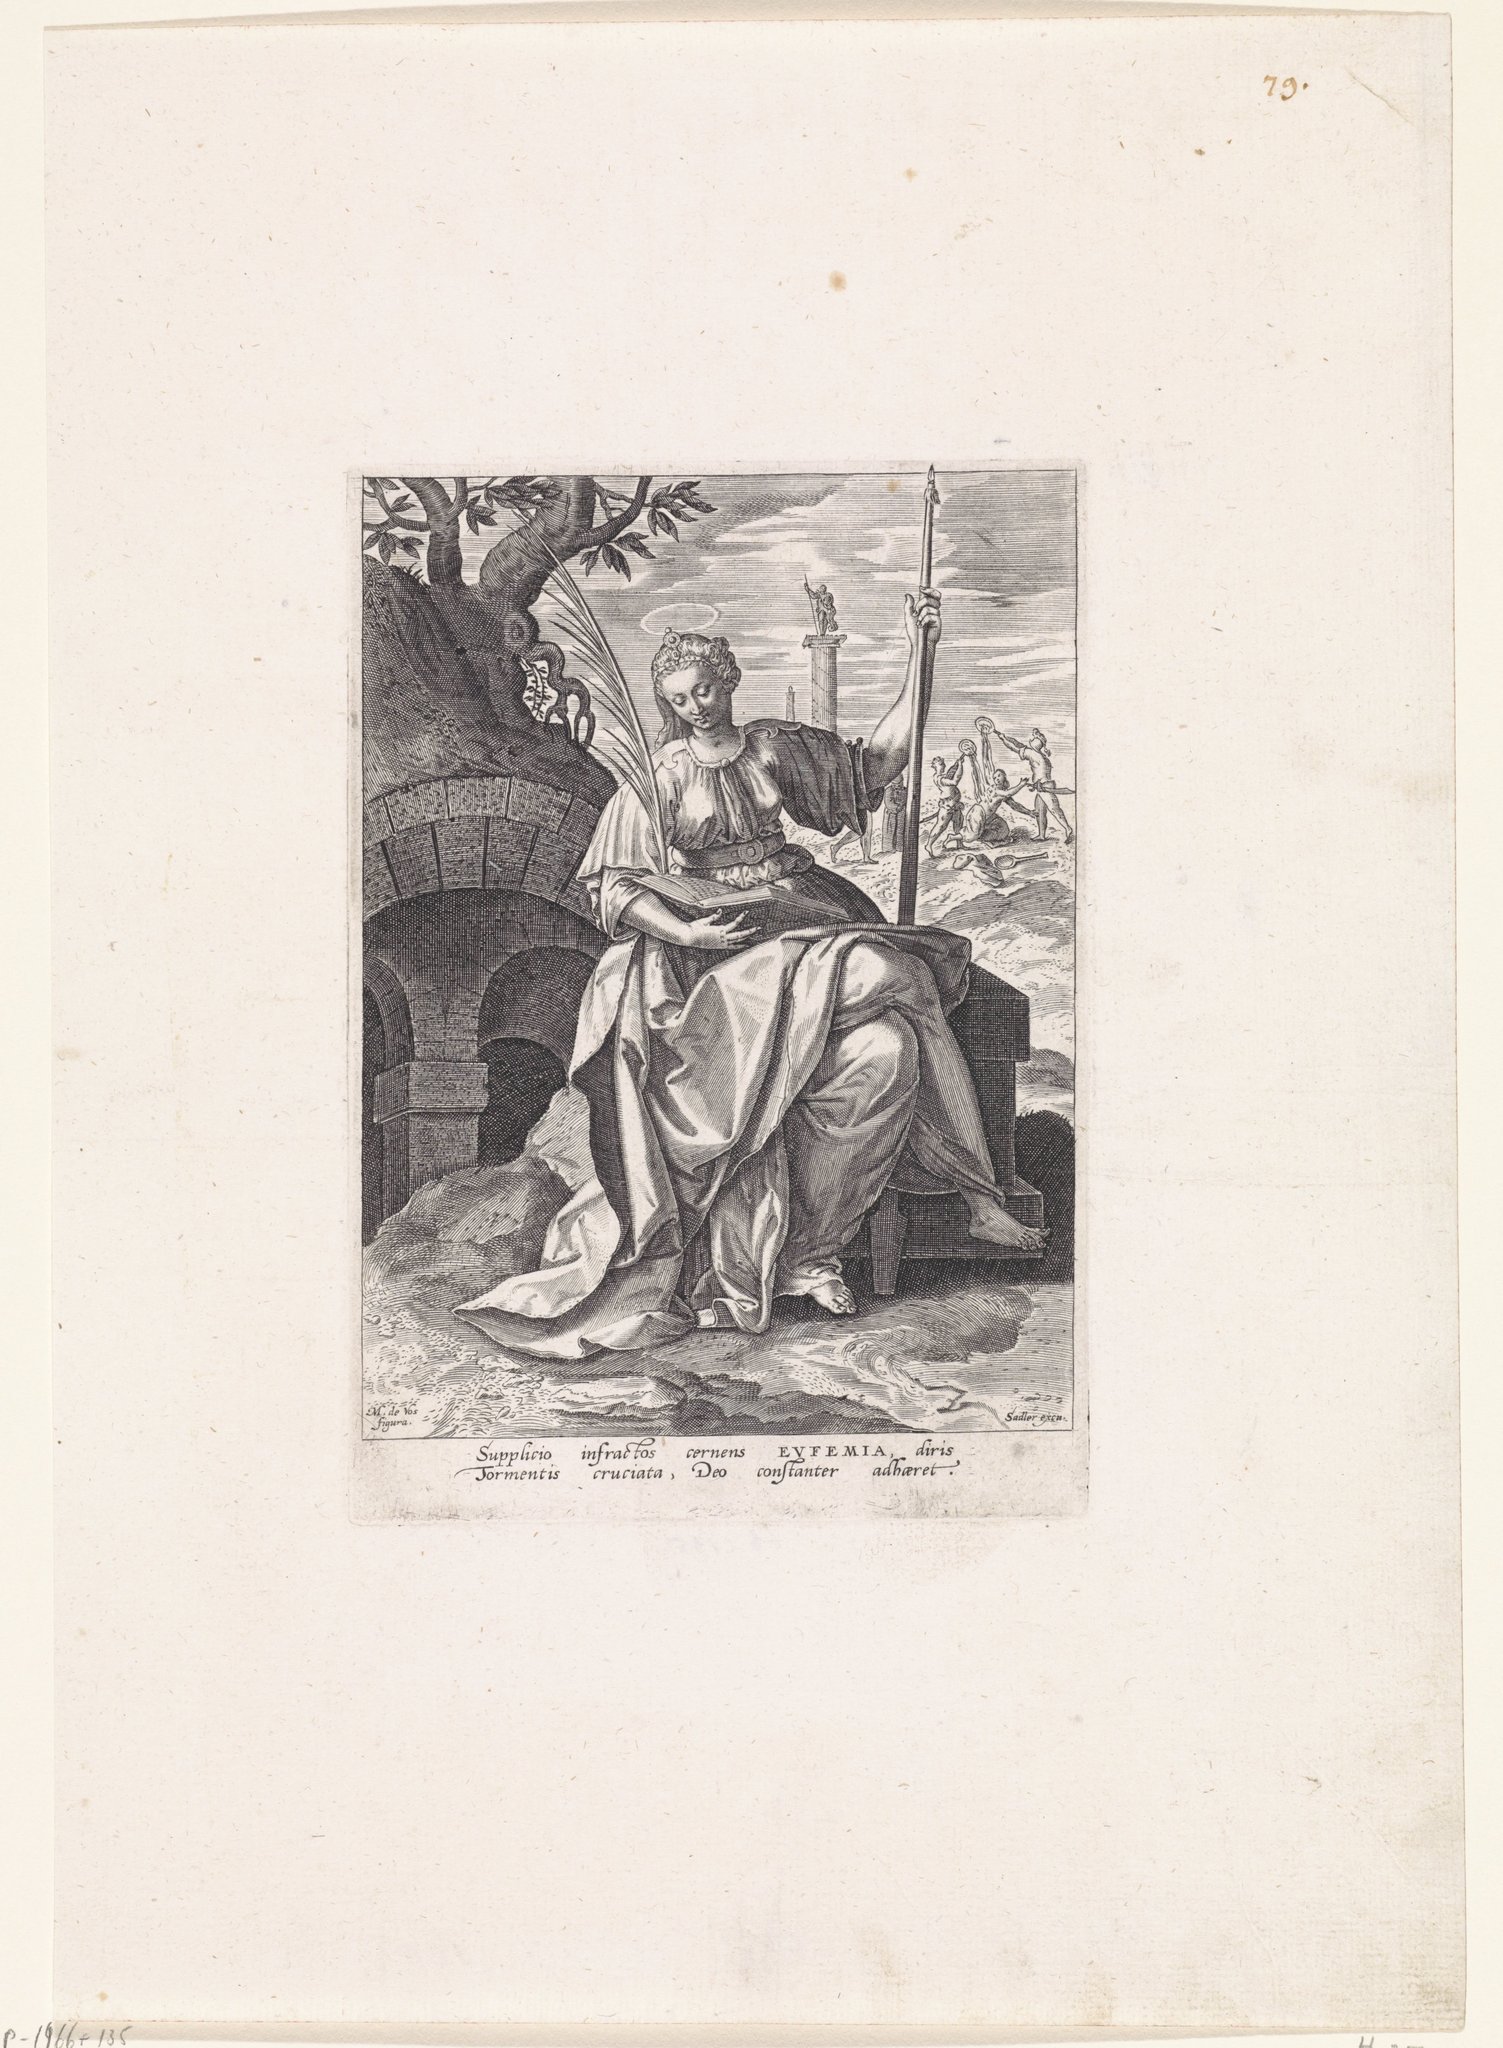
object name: print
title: Speculum Pudicitiae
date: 1583-1587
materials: paper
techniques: engraving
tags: female saints (eufemia)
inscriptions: number: ‘79’, collector's mark: Lugt 2228, collector's mark: Lugt 2760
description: De H. Euphemia, zittend, iets naar rechts gekeerd, het hoofd naar links. Ze leest een boek. In haar linkerhand een speer. Op de achtergrond wordt ze met kokende olie overgoten. De tiende prent van een zeventiendelige serie met vrouwelijke heiligen.